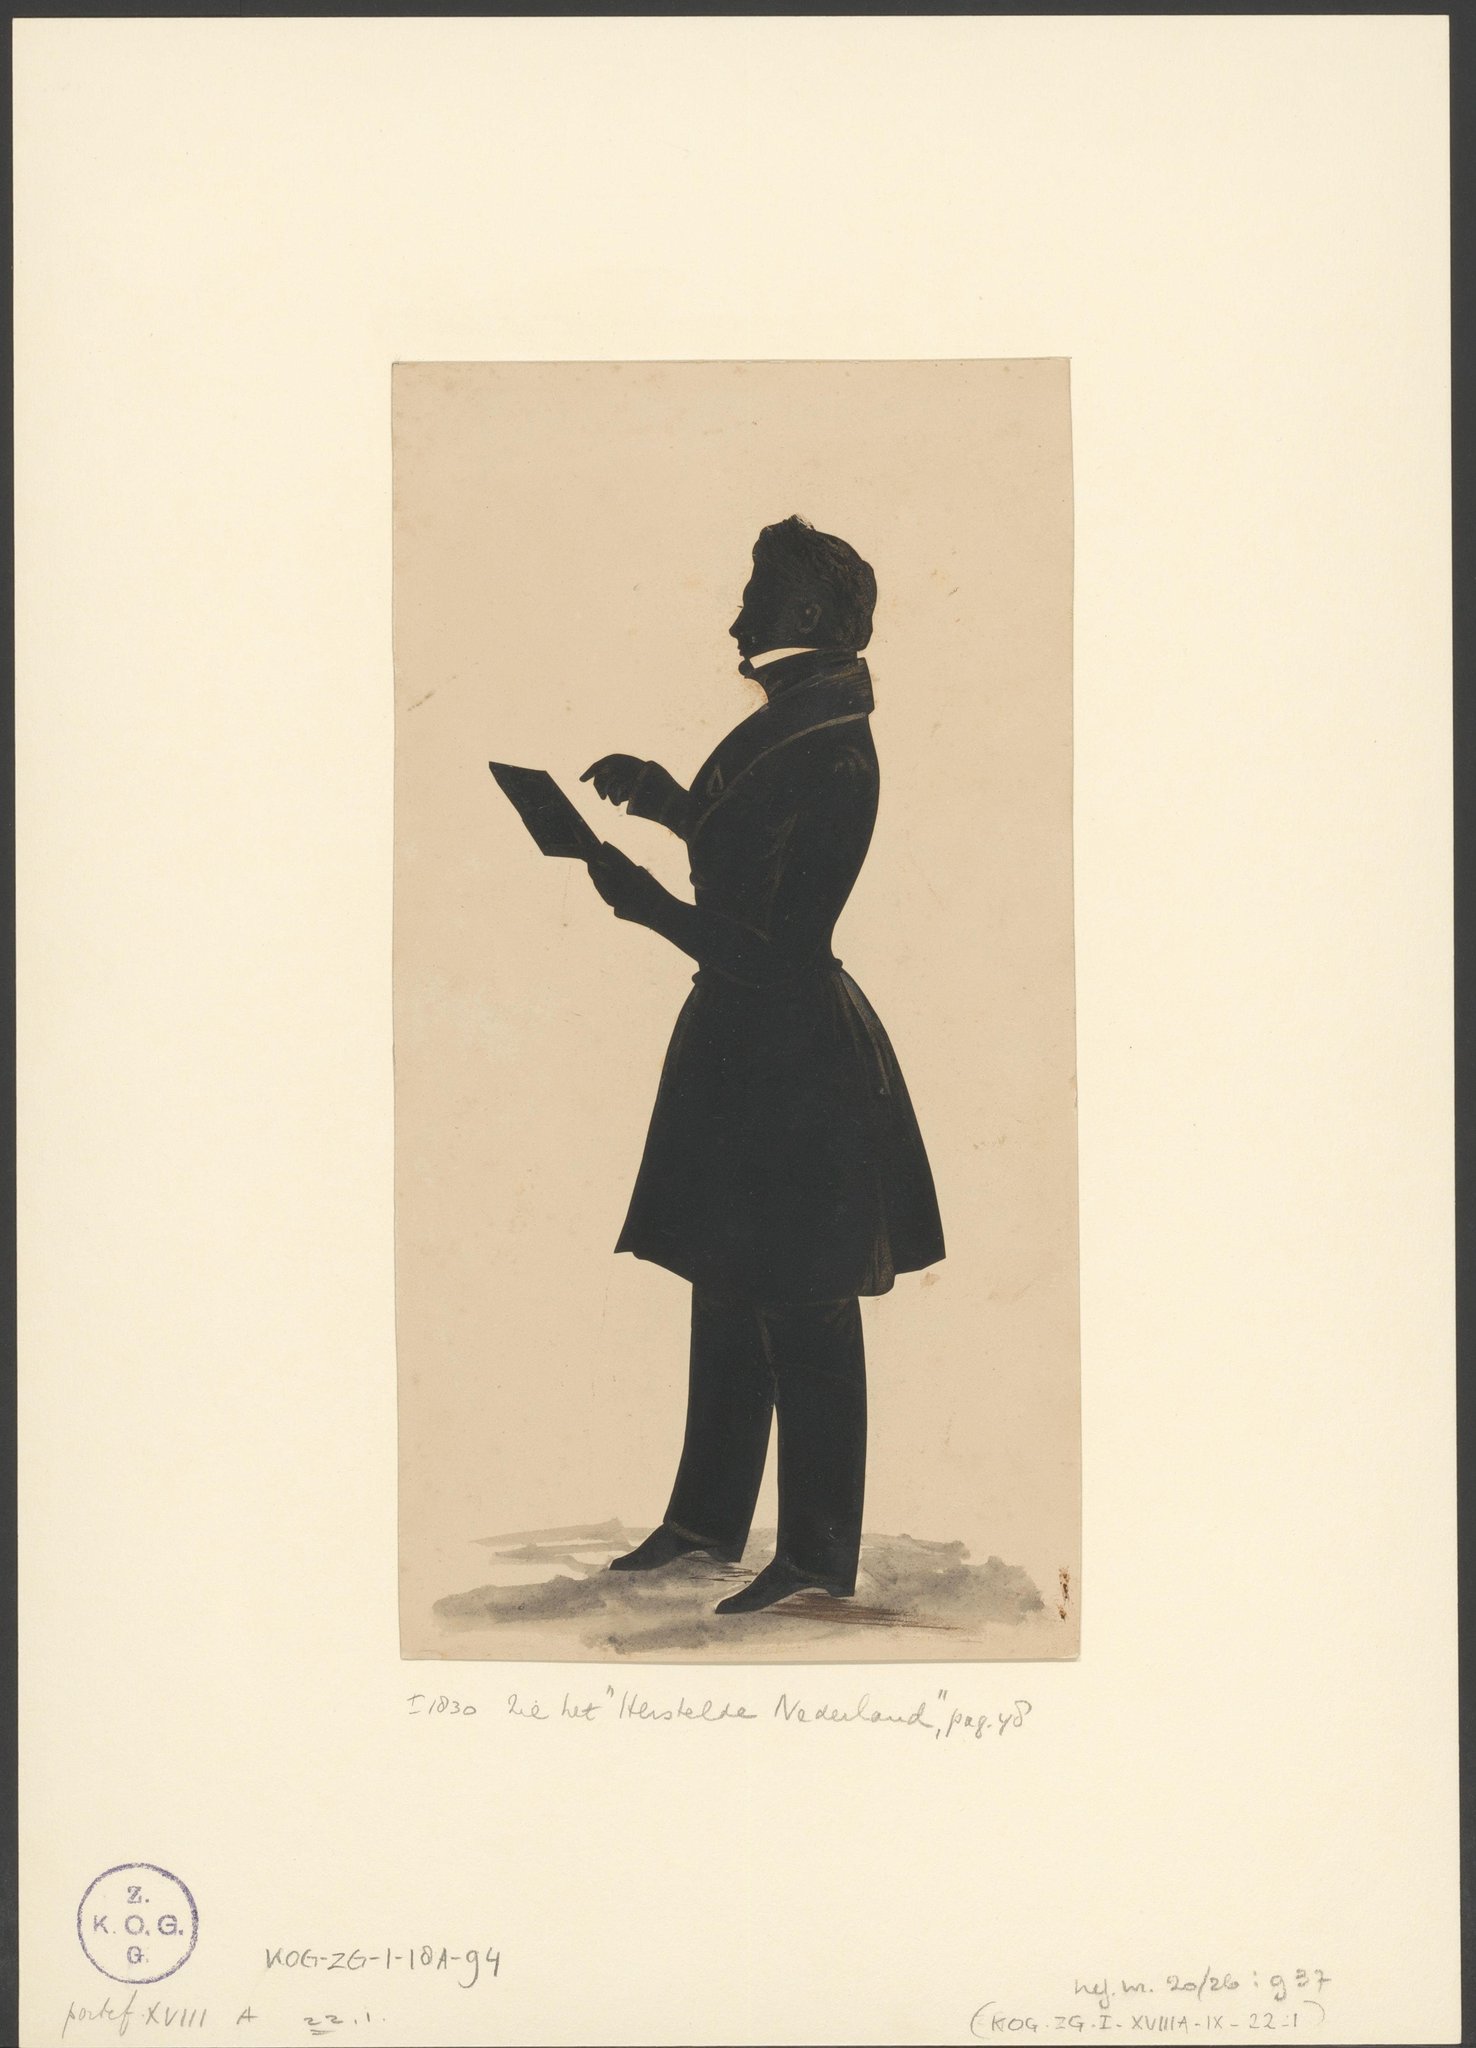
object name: silhouette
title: Silhouetportret van een Daniël Théodore Gevers van Endegeest, ten voeten uit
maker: edward s. haines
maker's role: knipkunstenaar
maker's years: 1801-1866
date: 1811-1866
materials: cardboard, ink, paint, paper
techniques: brush, snipping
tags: rotterdam, standing figure, historical persons, book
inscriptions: collector's mark: Lugt 1641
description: Onderwerpsrubrieken binnen de Atlas Zeden en Gewoonten: Schoone kunsten, Silhouetportretten.